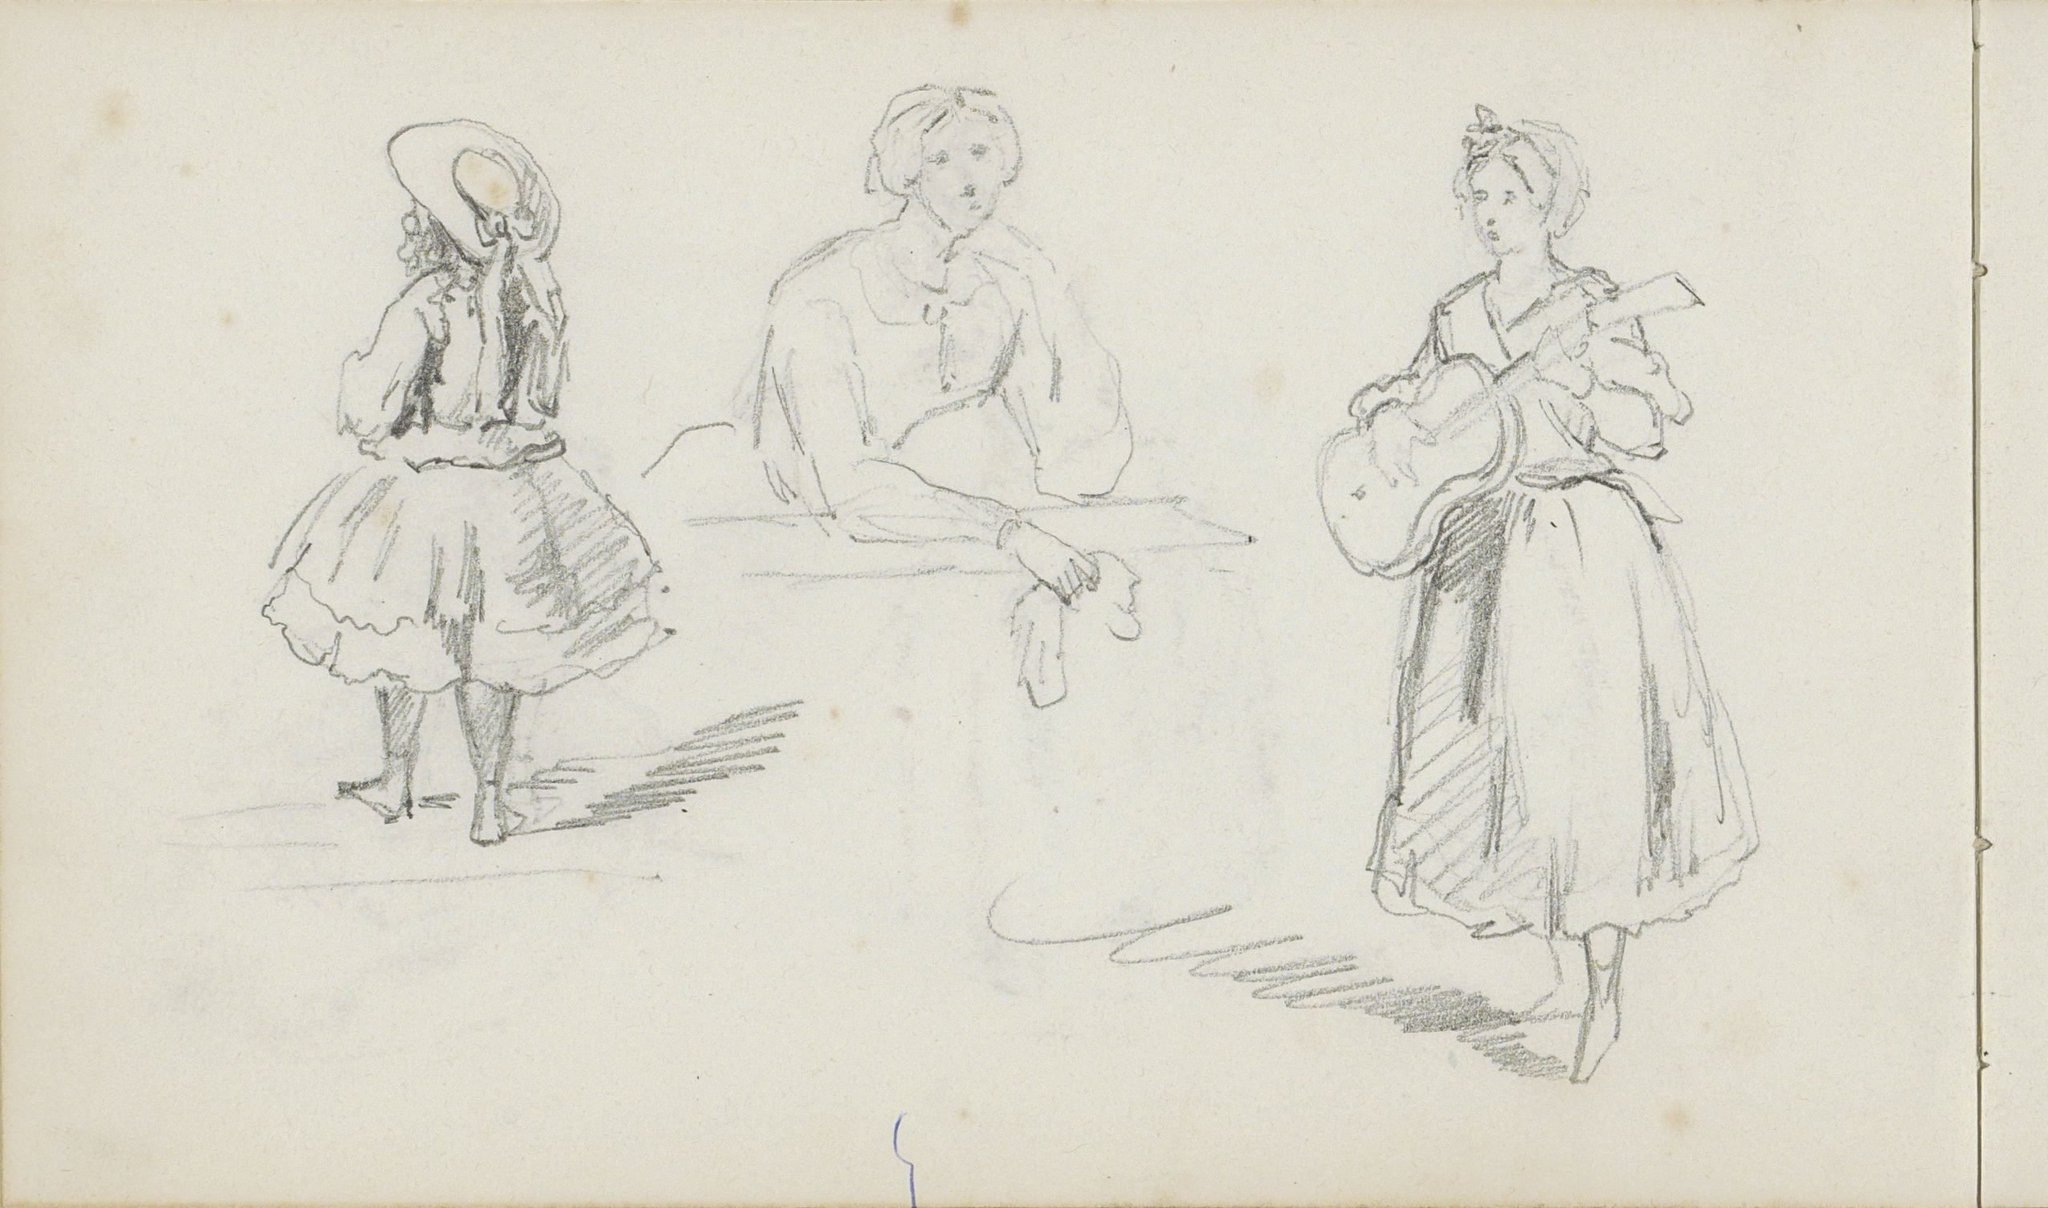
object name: sketchbook leaf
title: Meisje met hoed, vrouw met een doek en een gitaarspeelster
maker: charles rochussen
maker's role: draughtsman, painter, print maker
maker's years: 1814-1894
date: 1840-1860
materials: paper, pencil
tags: girl (child between toddler and youth), cithern, mandolin, guitar, balalaika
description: Blad 7 verso uit een schetsboek met 38 bladen.